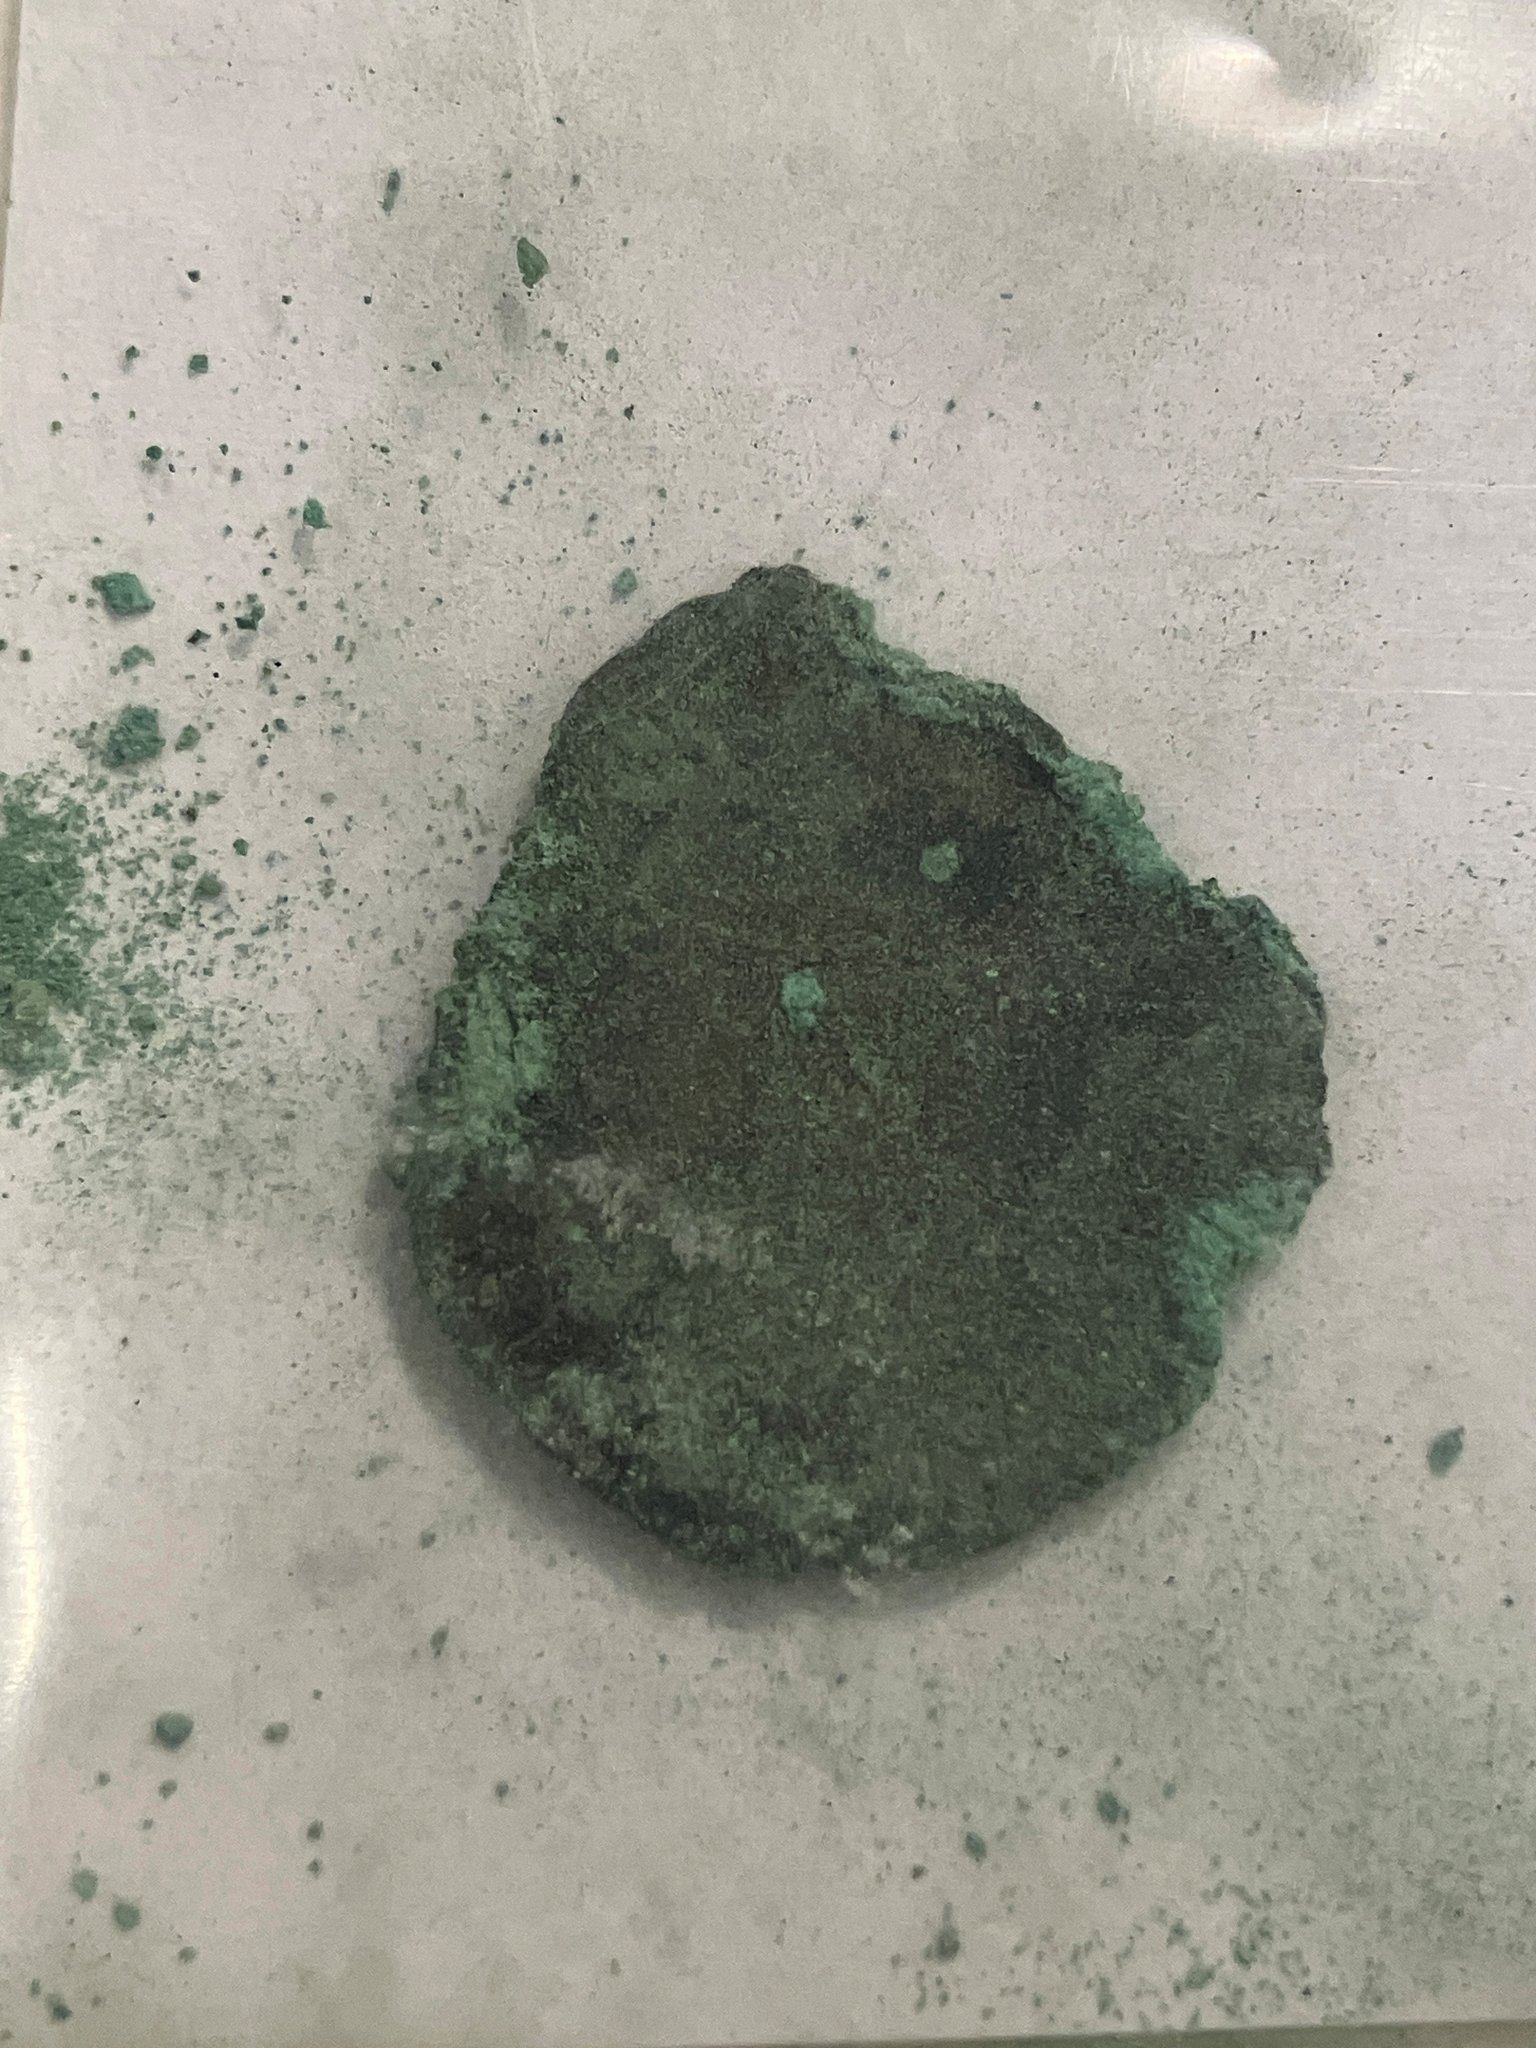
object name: coin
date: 401-1400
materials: silver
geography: iran